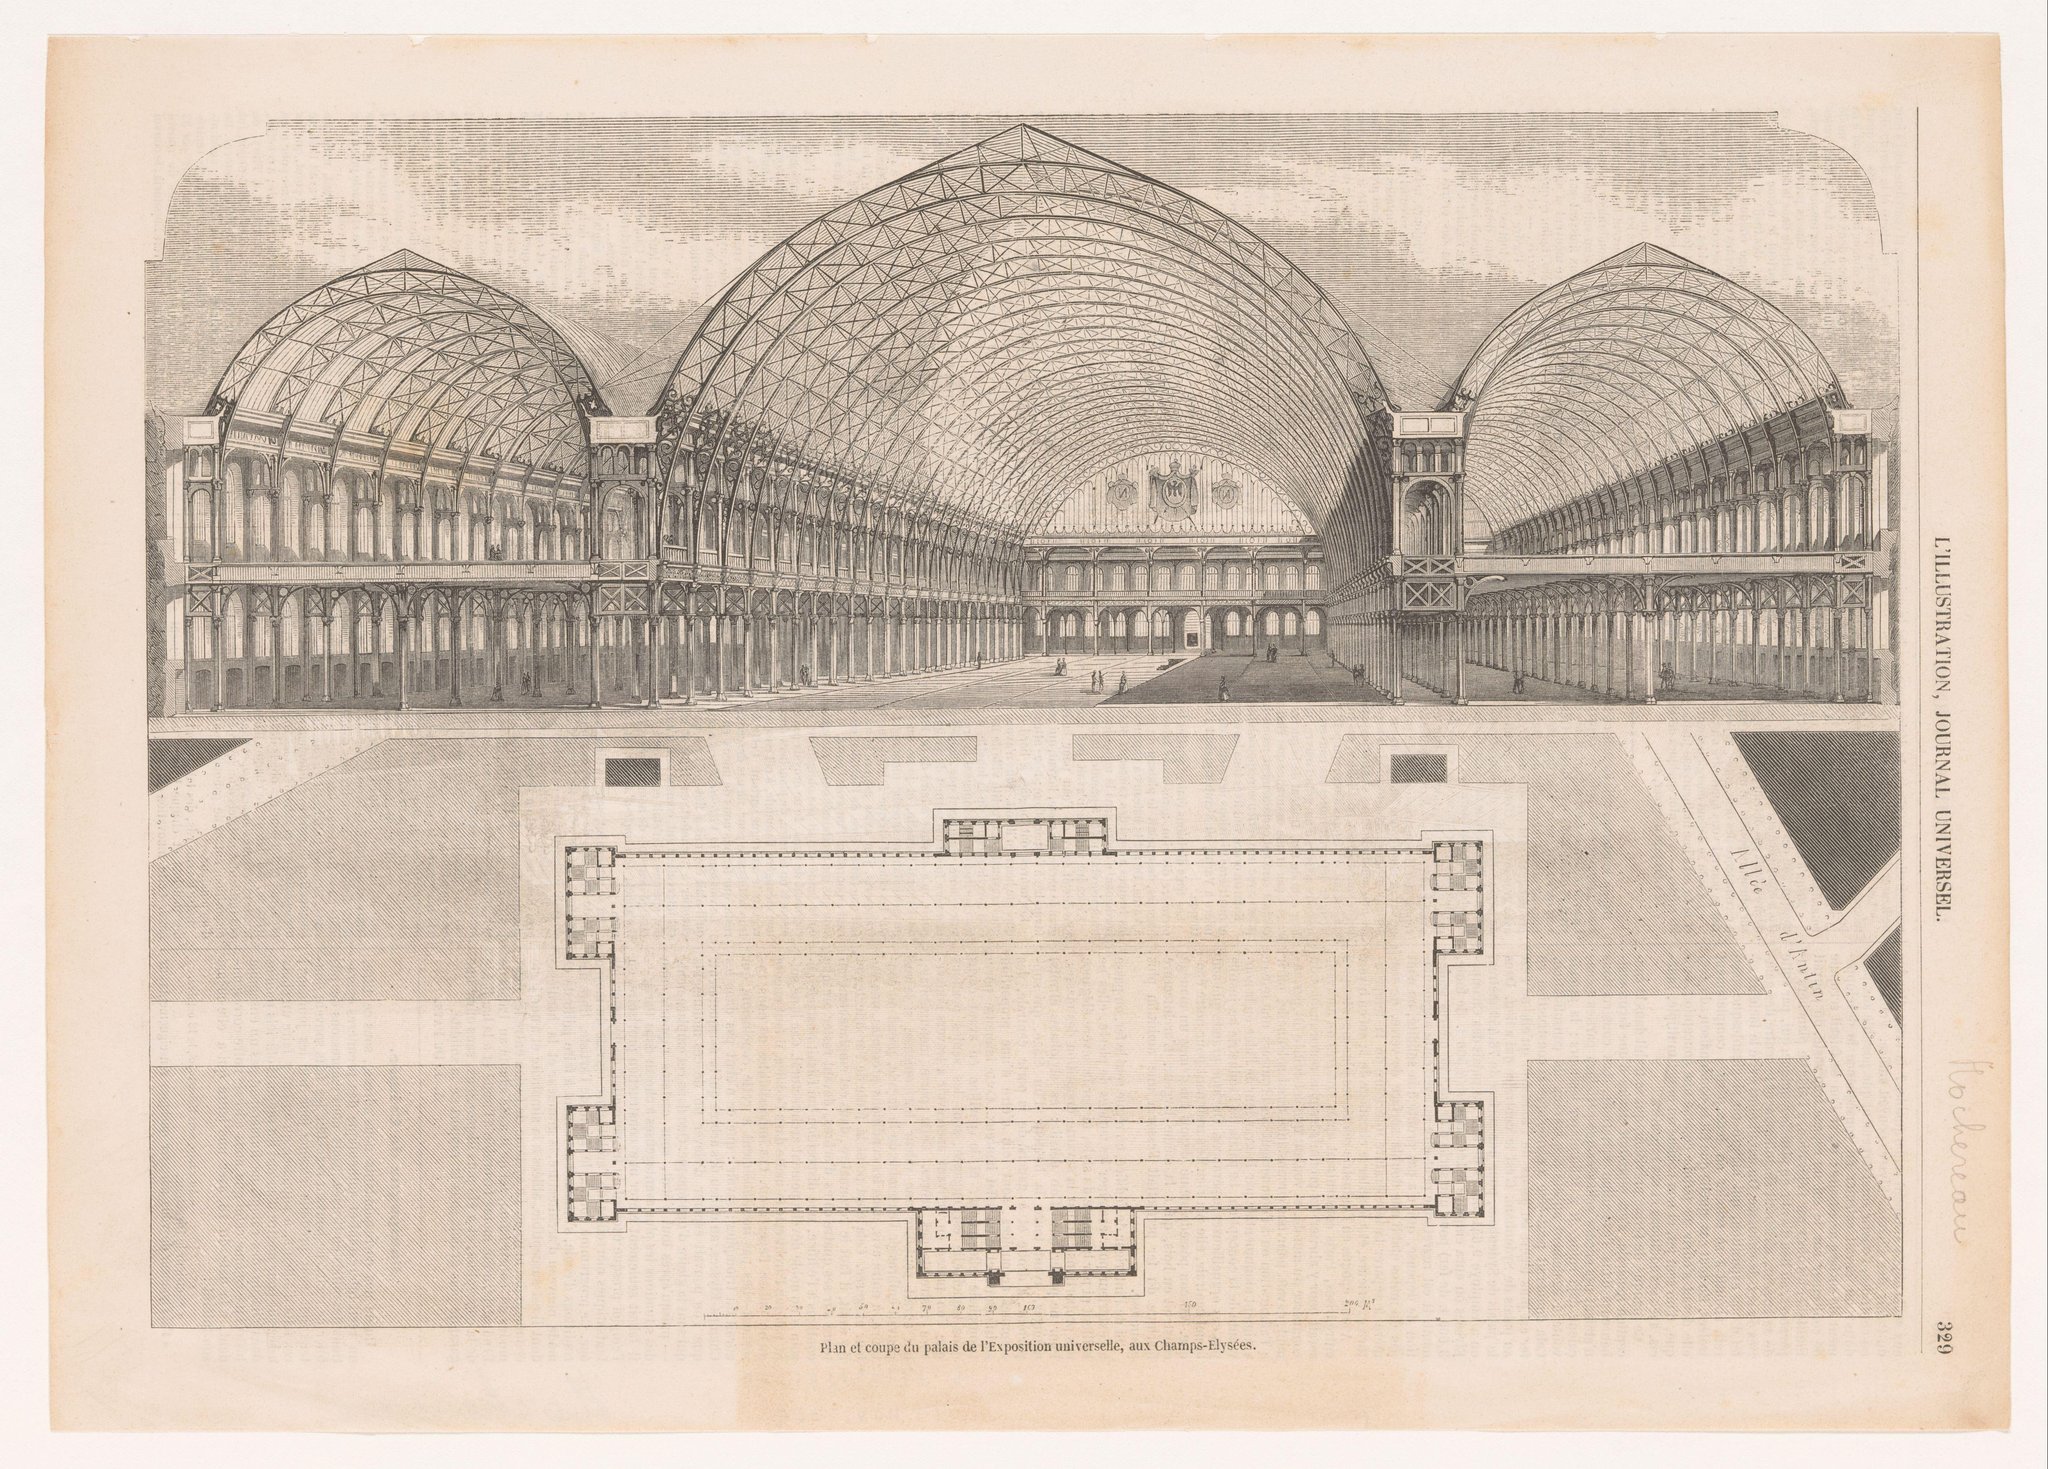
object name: print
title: Gezicht op het interieur van het Palais de l'Industrie met plattegrond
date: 1854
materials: paper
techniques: letterpress printing, engraving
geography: paris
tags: world fair, world exhibition, paris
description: Prent uit: L'Illustration, vol. 24, nr. 611, 11 november 1854, p. 329.